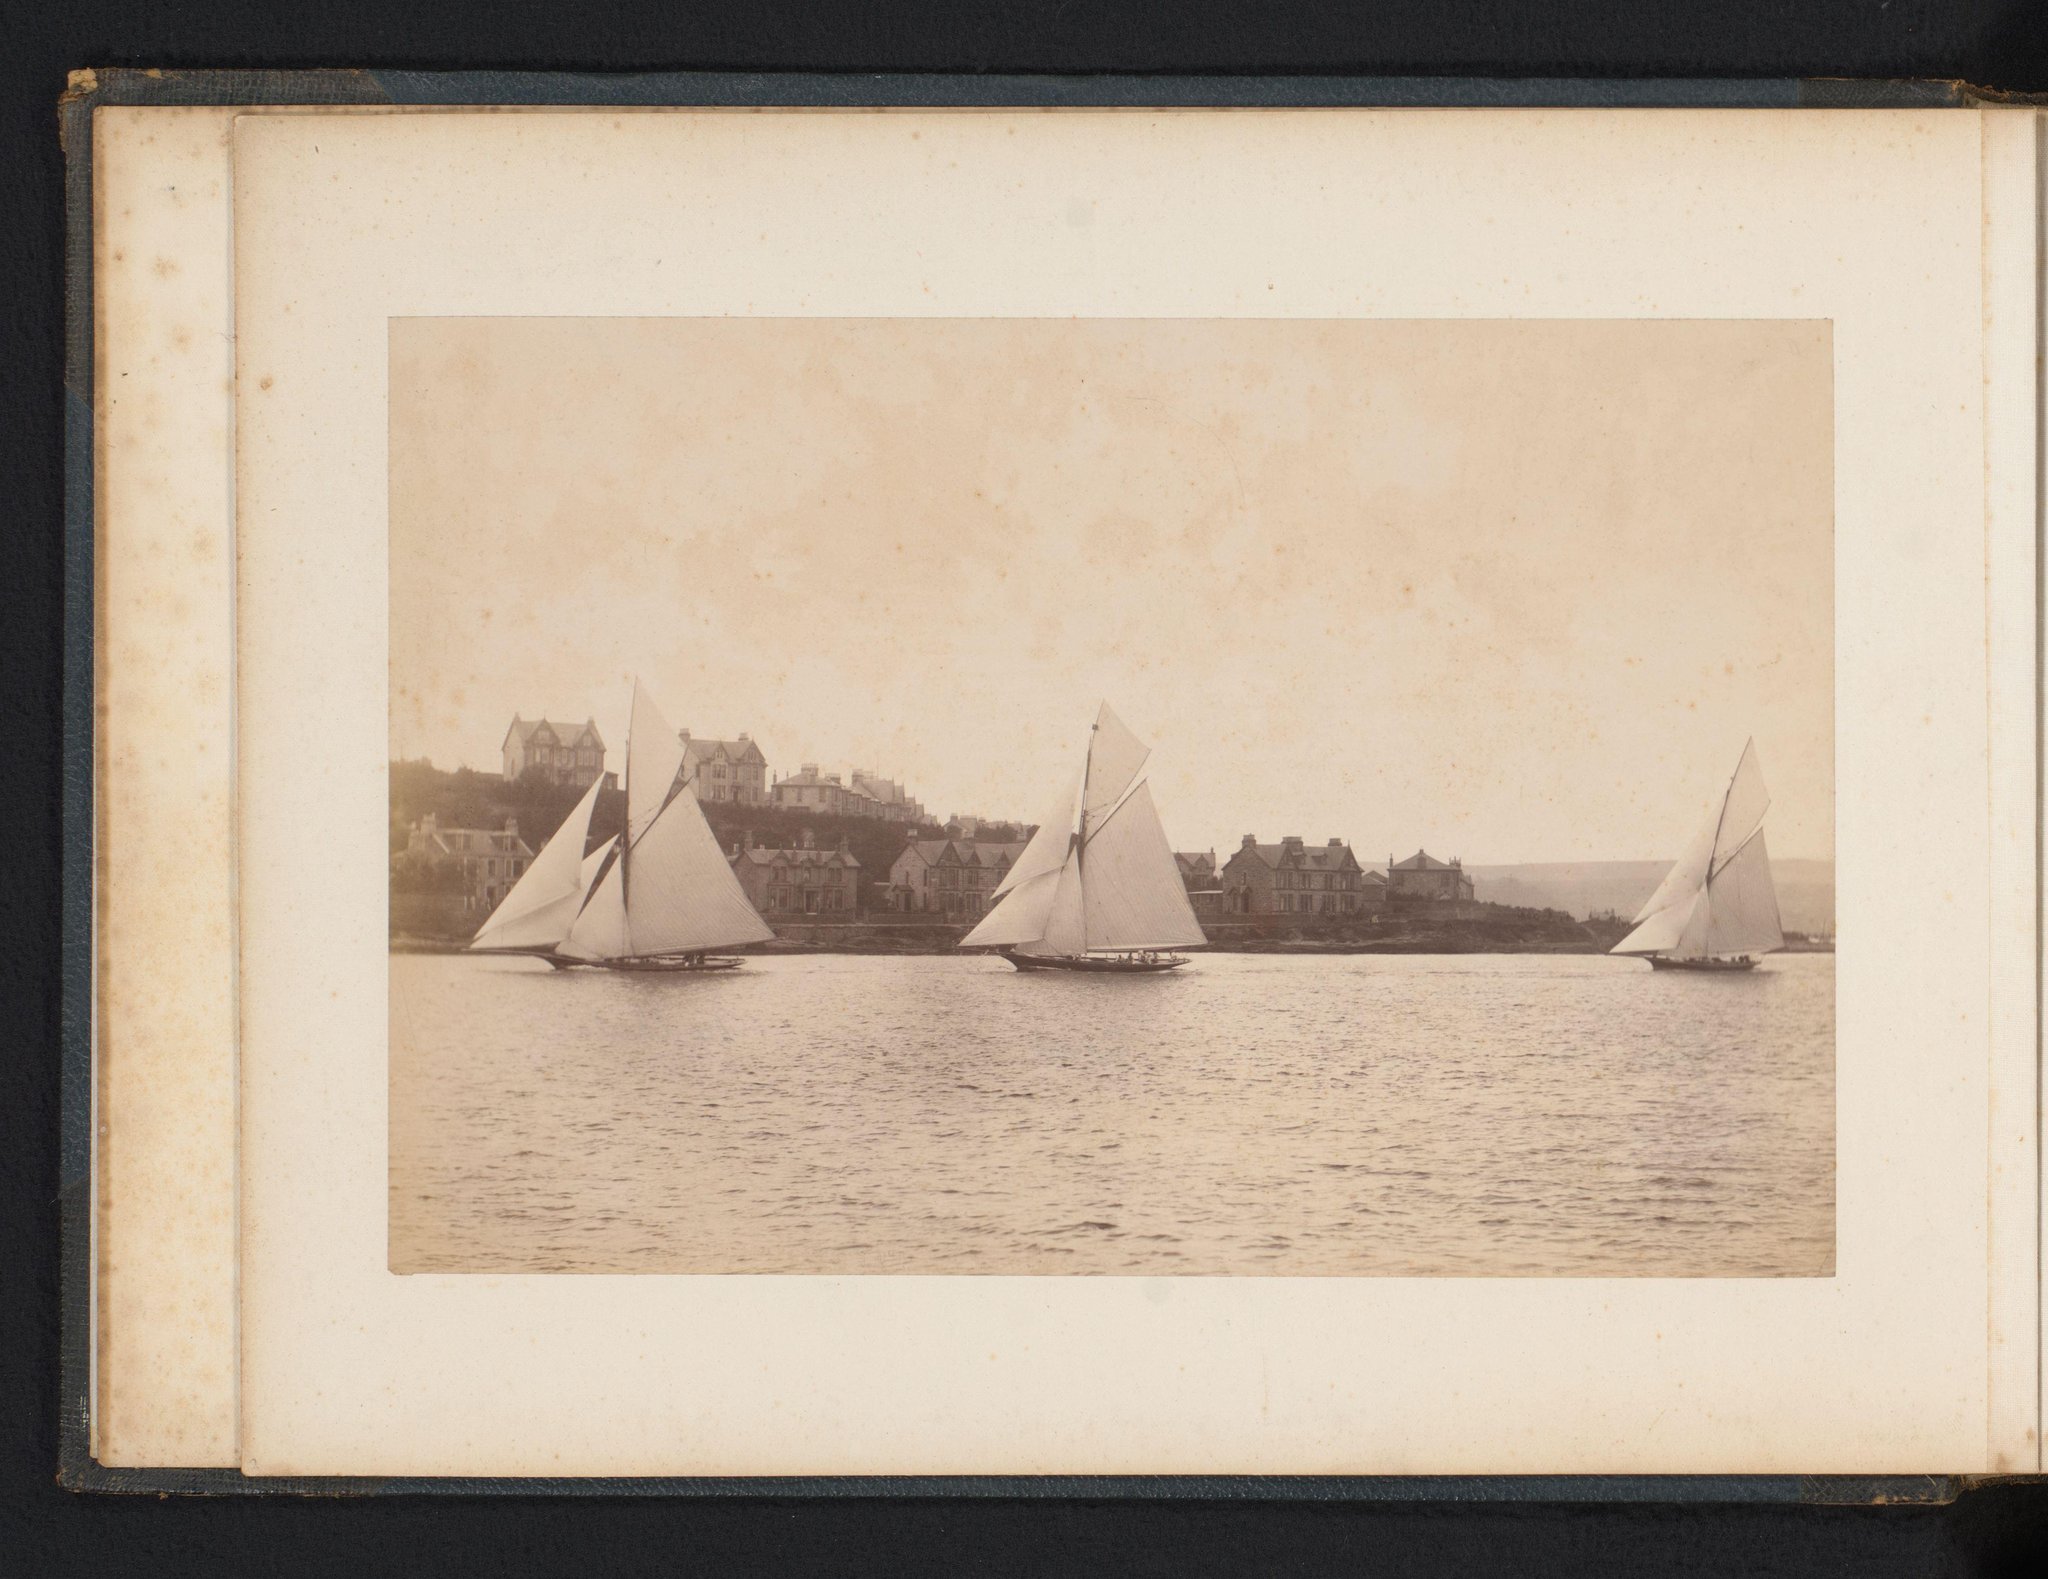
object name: photograph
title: Zeilschepen Yvonne, Doris en Darthula te water met op de achtergrond bebouwing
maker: james adamson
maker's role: fotograaf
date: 1880-1900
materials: photographic support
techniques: albumen print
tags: sailing-ship, sailing-boat, landscapes with waters, waterscapes, seascapes (in the temperate zone), civic architecture; edifices; dwellings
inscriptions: check stamp: ‘Adamson, Rothesay.H.B’